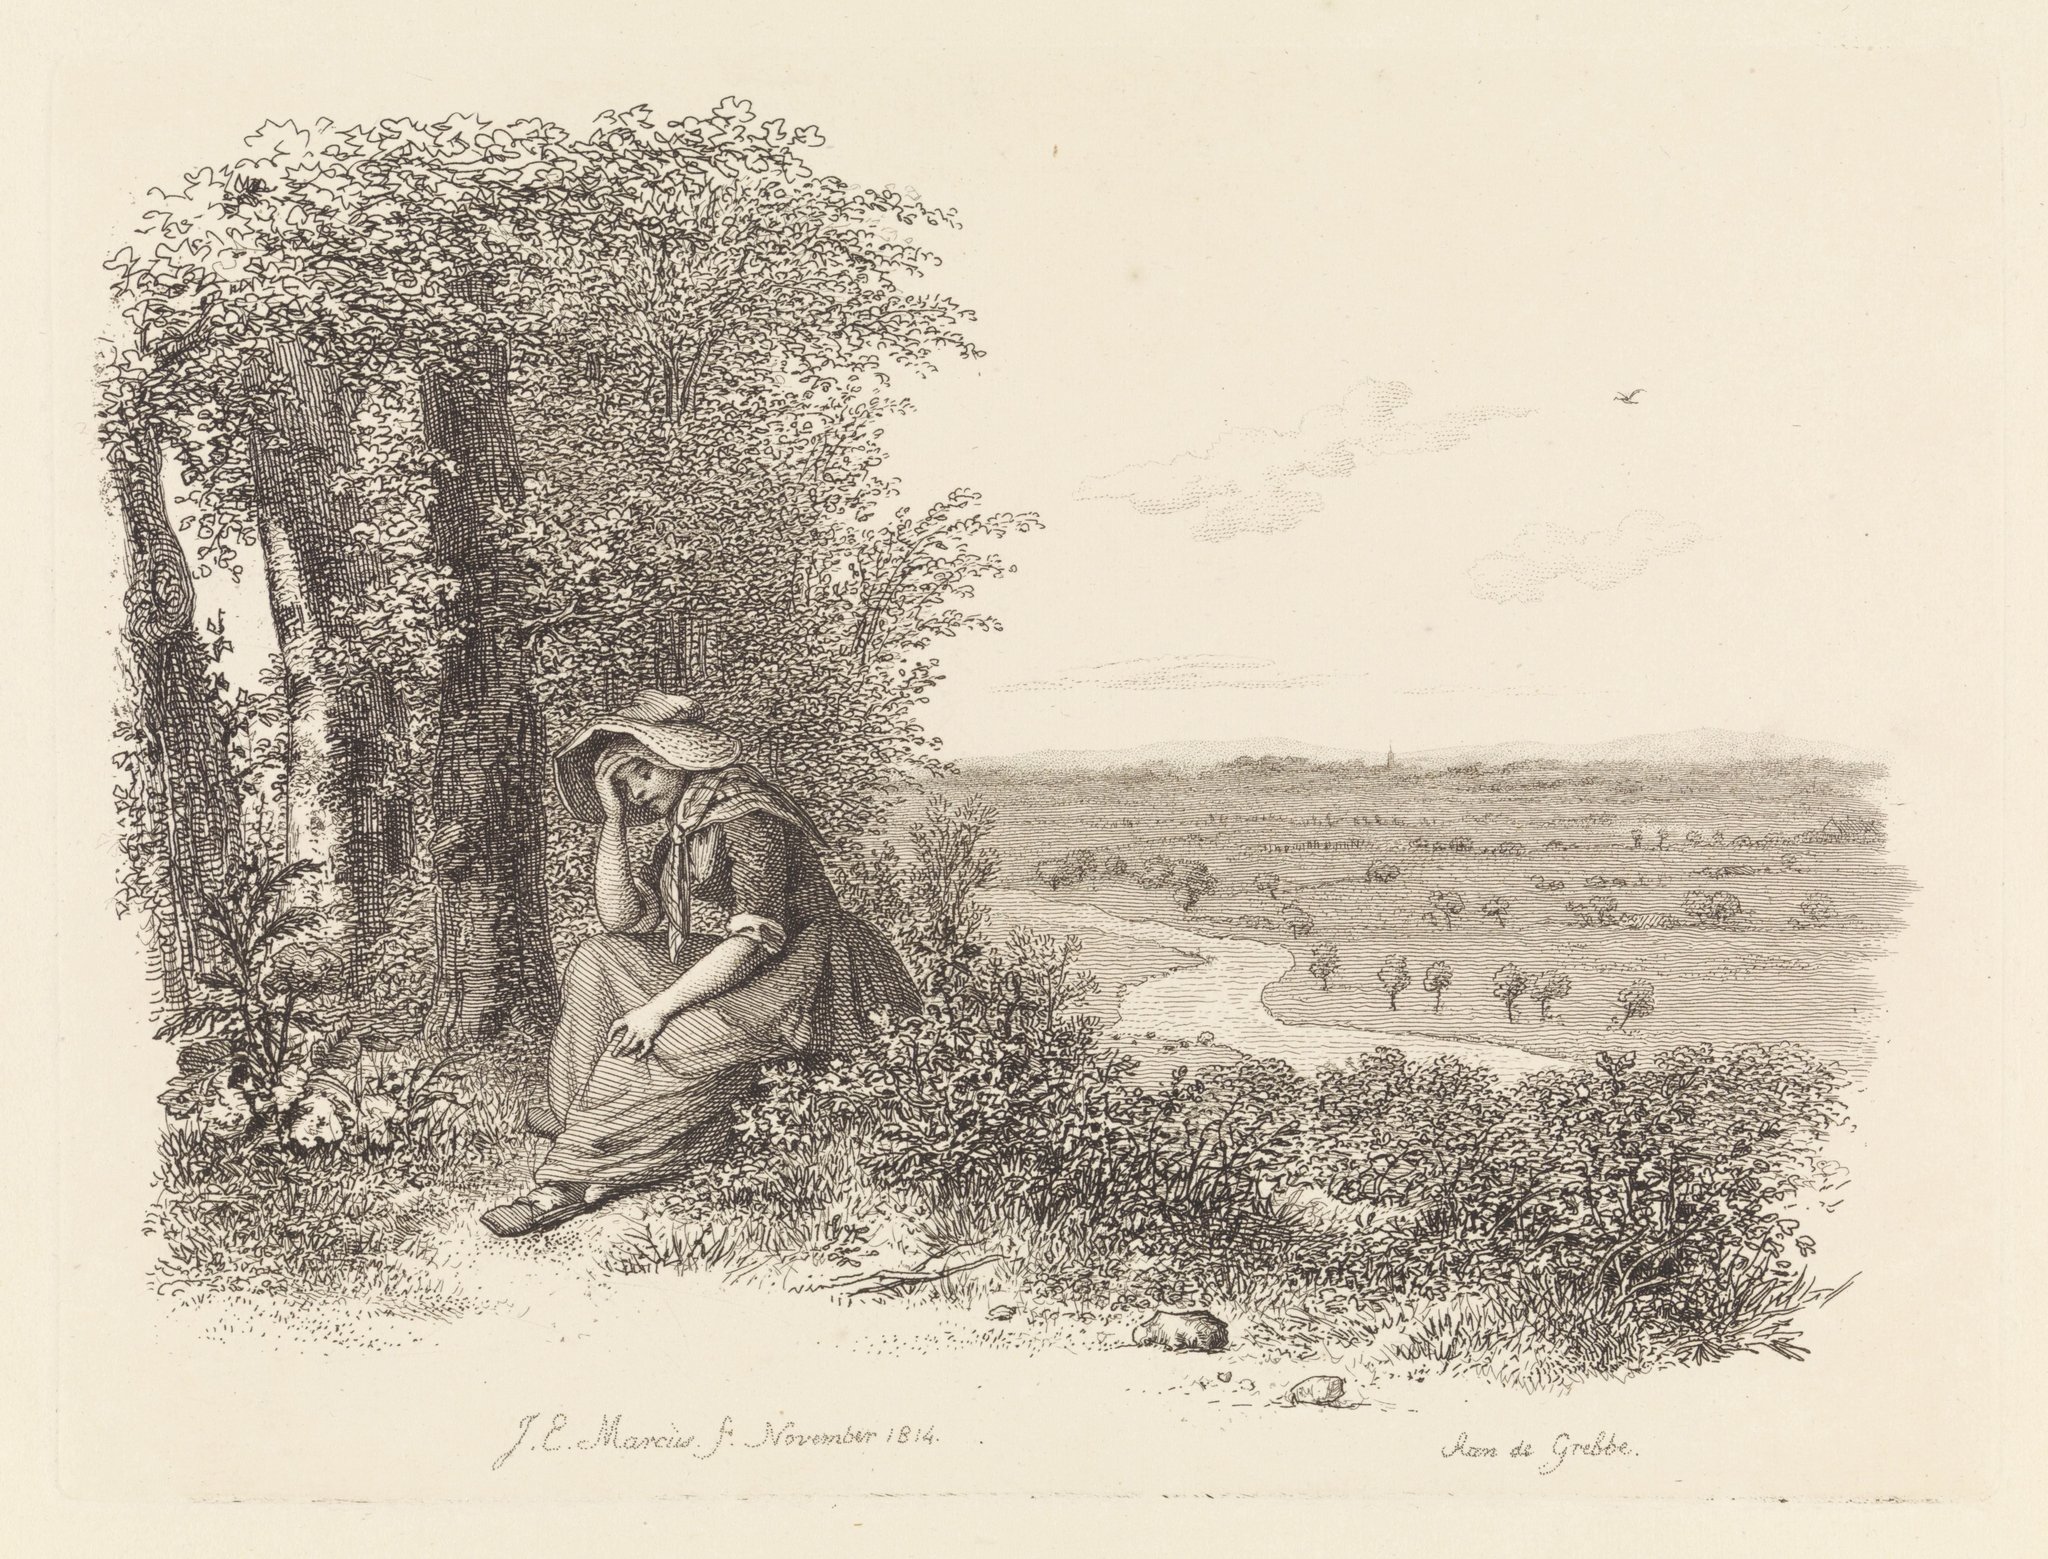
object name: print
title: Zittende vrouw in een landschap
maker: jacob ernst marcus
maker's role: draughtsman, print maker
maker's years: 1774-1826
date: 1811-1814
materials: paper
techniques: etching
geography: amsterdam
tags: sitting with arms or elbows on the knees - aa - female human figure, sitting on the ground - aa - female human figure, river (+ landscape with figures, staffage)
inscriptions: collector's mark: Lugt 2228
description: Serie voor het eerst uitgegeven door Jacob Ernst Marcus onder de titel Studiebeelden en Fragmenten. Amsterdam: ca.1816. Later heruitgegeven als: Studie-prentwerk/ Etudes gravées.